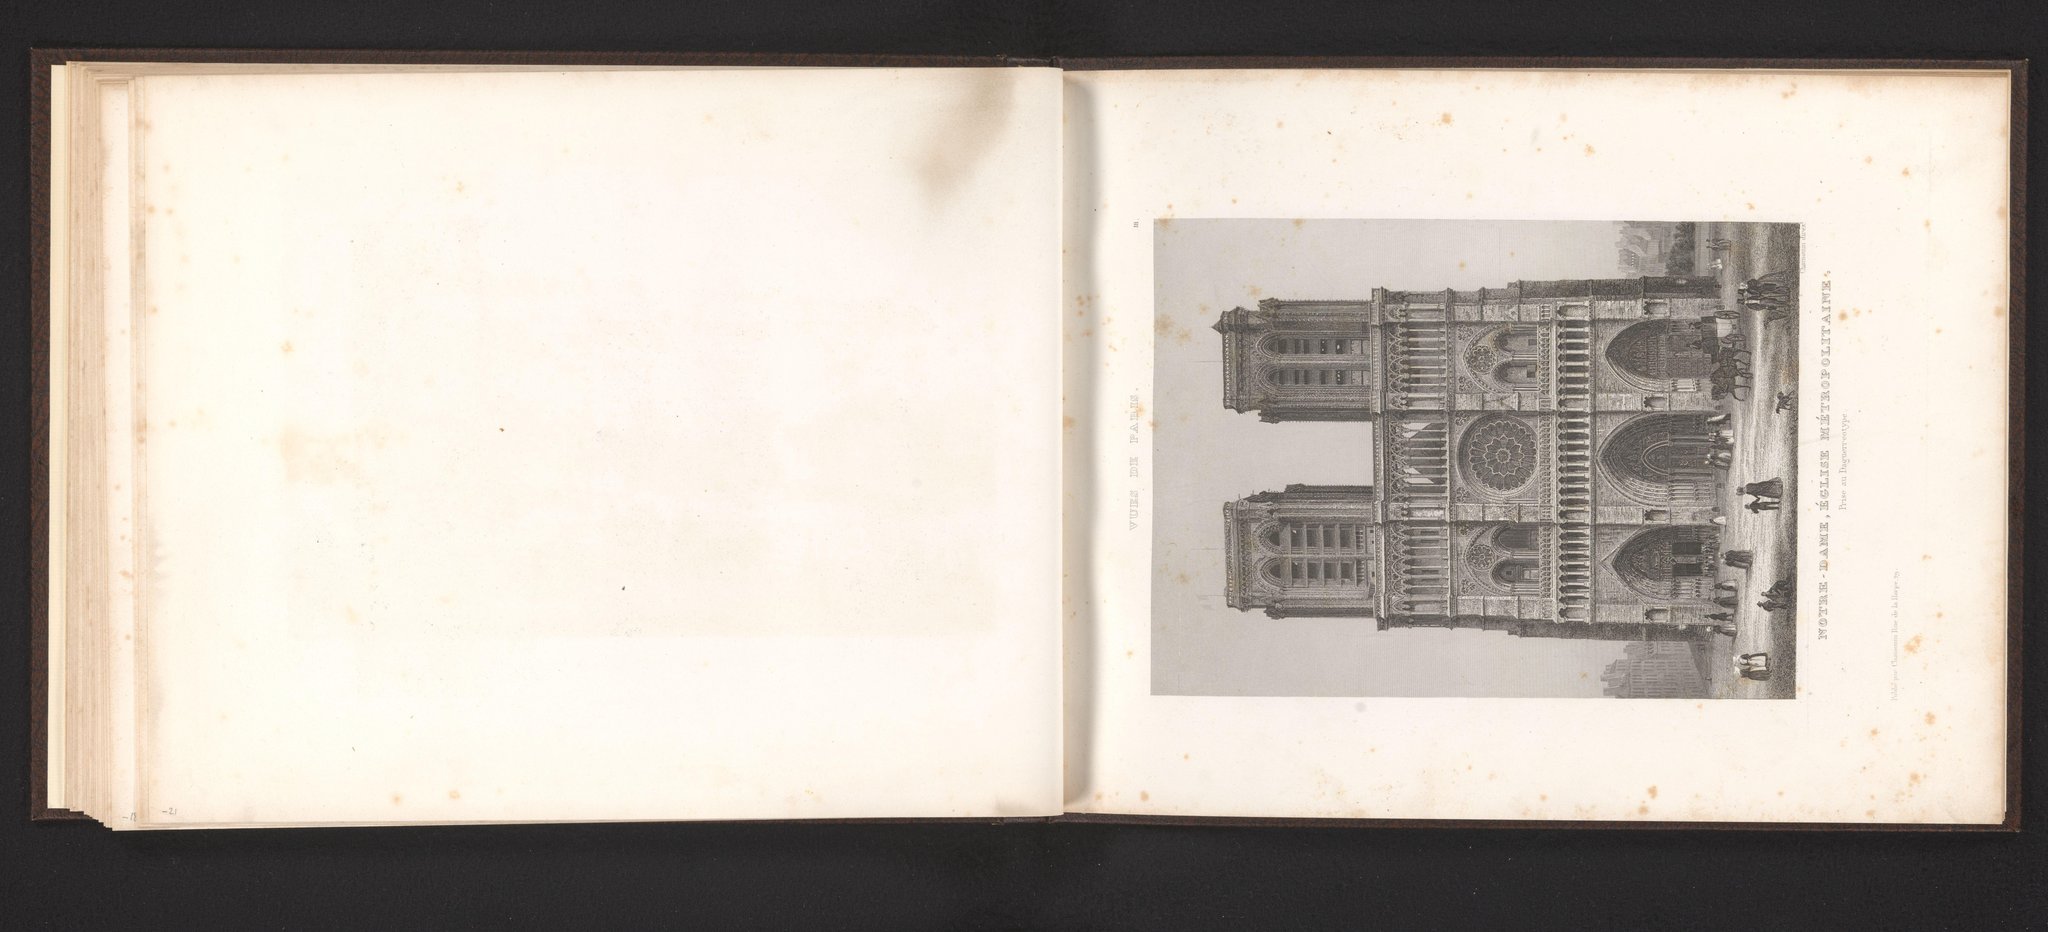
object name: print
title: Vues de Paris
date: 1845-1850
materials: paper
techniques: engraving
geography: paris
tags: church (exterior)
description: Prent op tweeëntwintigste ongenummerde pagina na titelpagina. Prent gemaakt naar daguerreotypie.